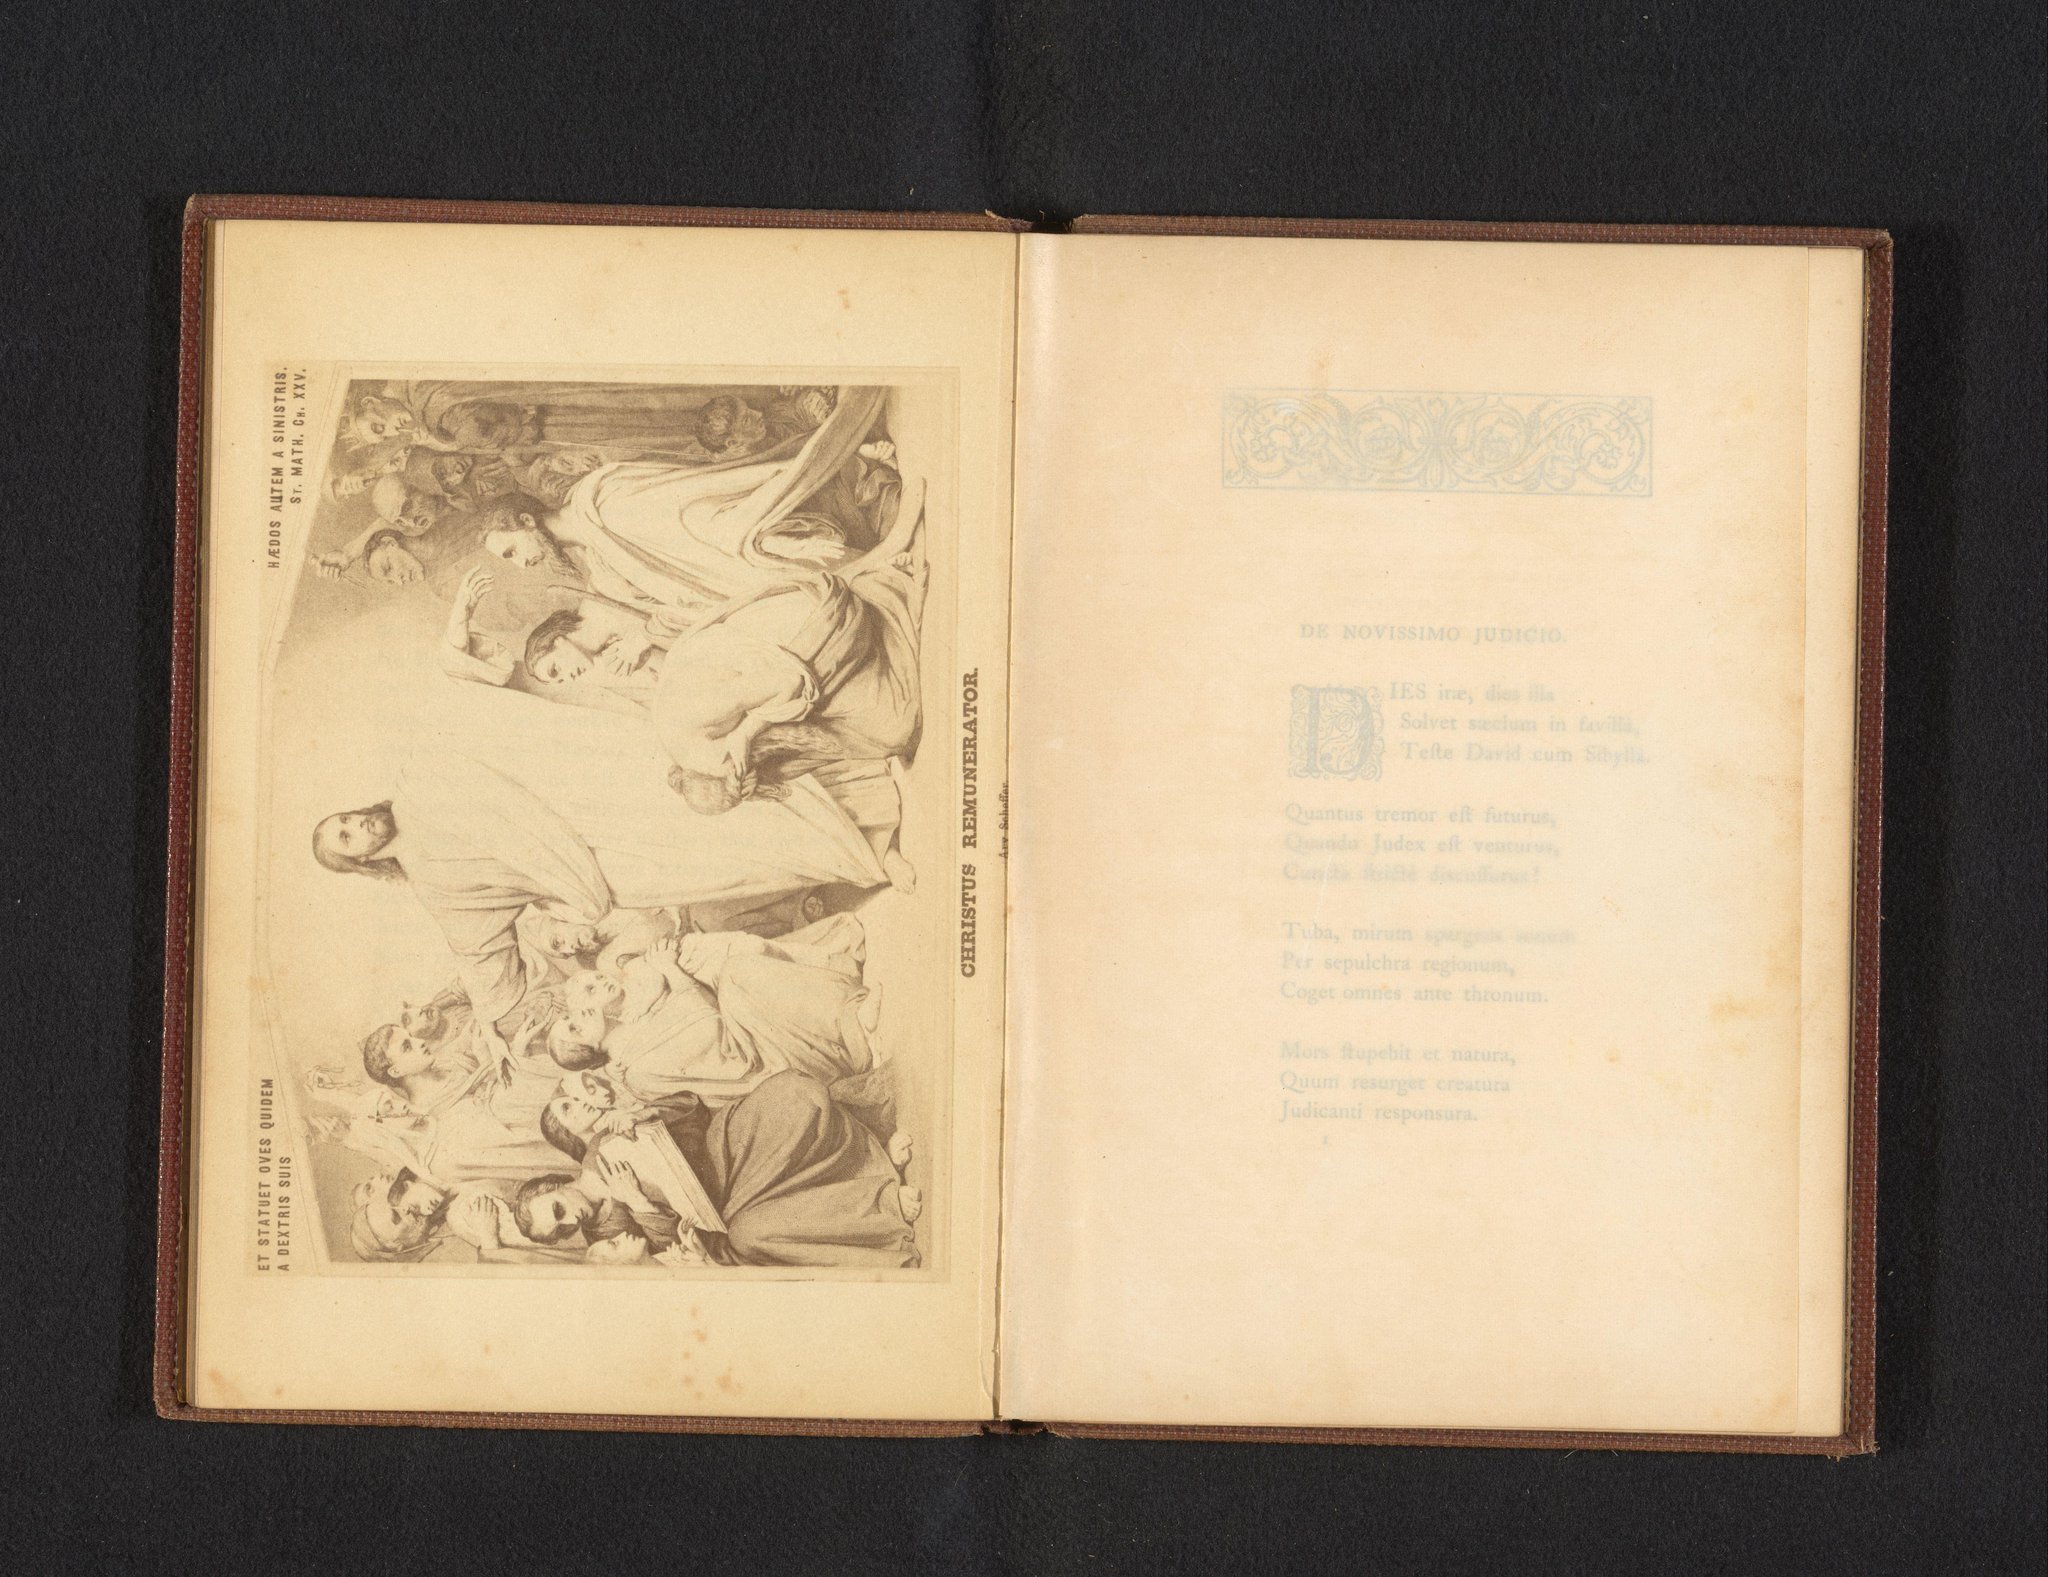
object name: reproduction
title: Christus Remunerator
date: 1854-1859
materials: photographic support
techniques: albumen print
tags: adult christ together with apostles, evangelists, saints, etc.